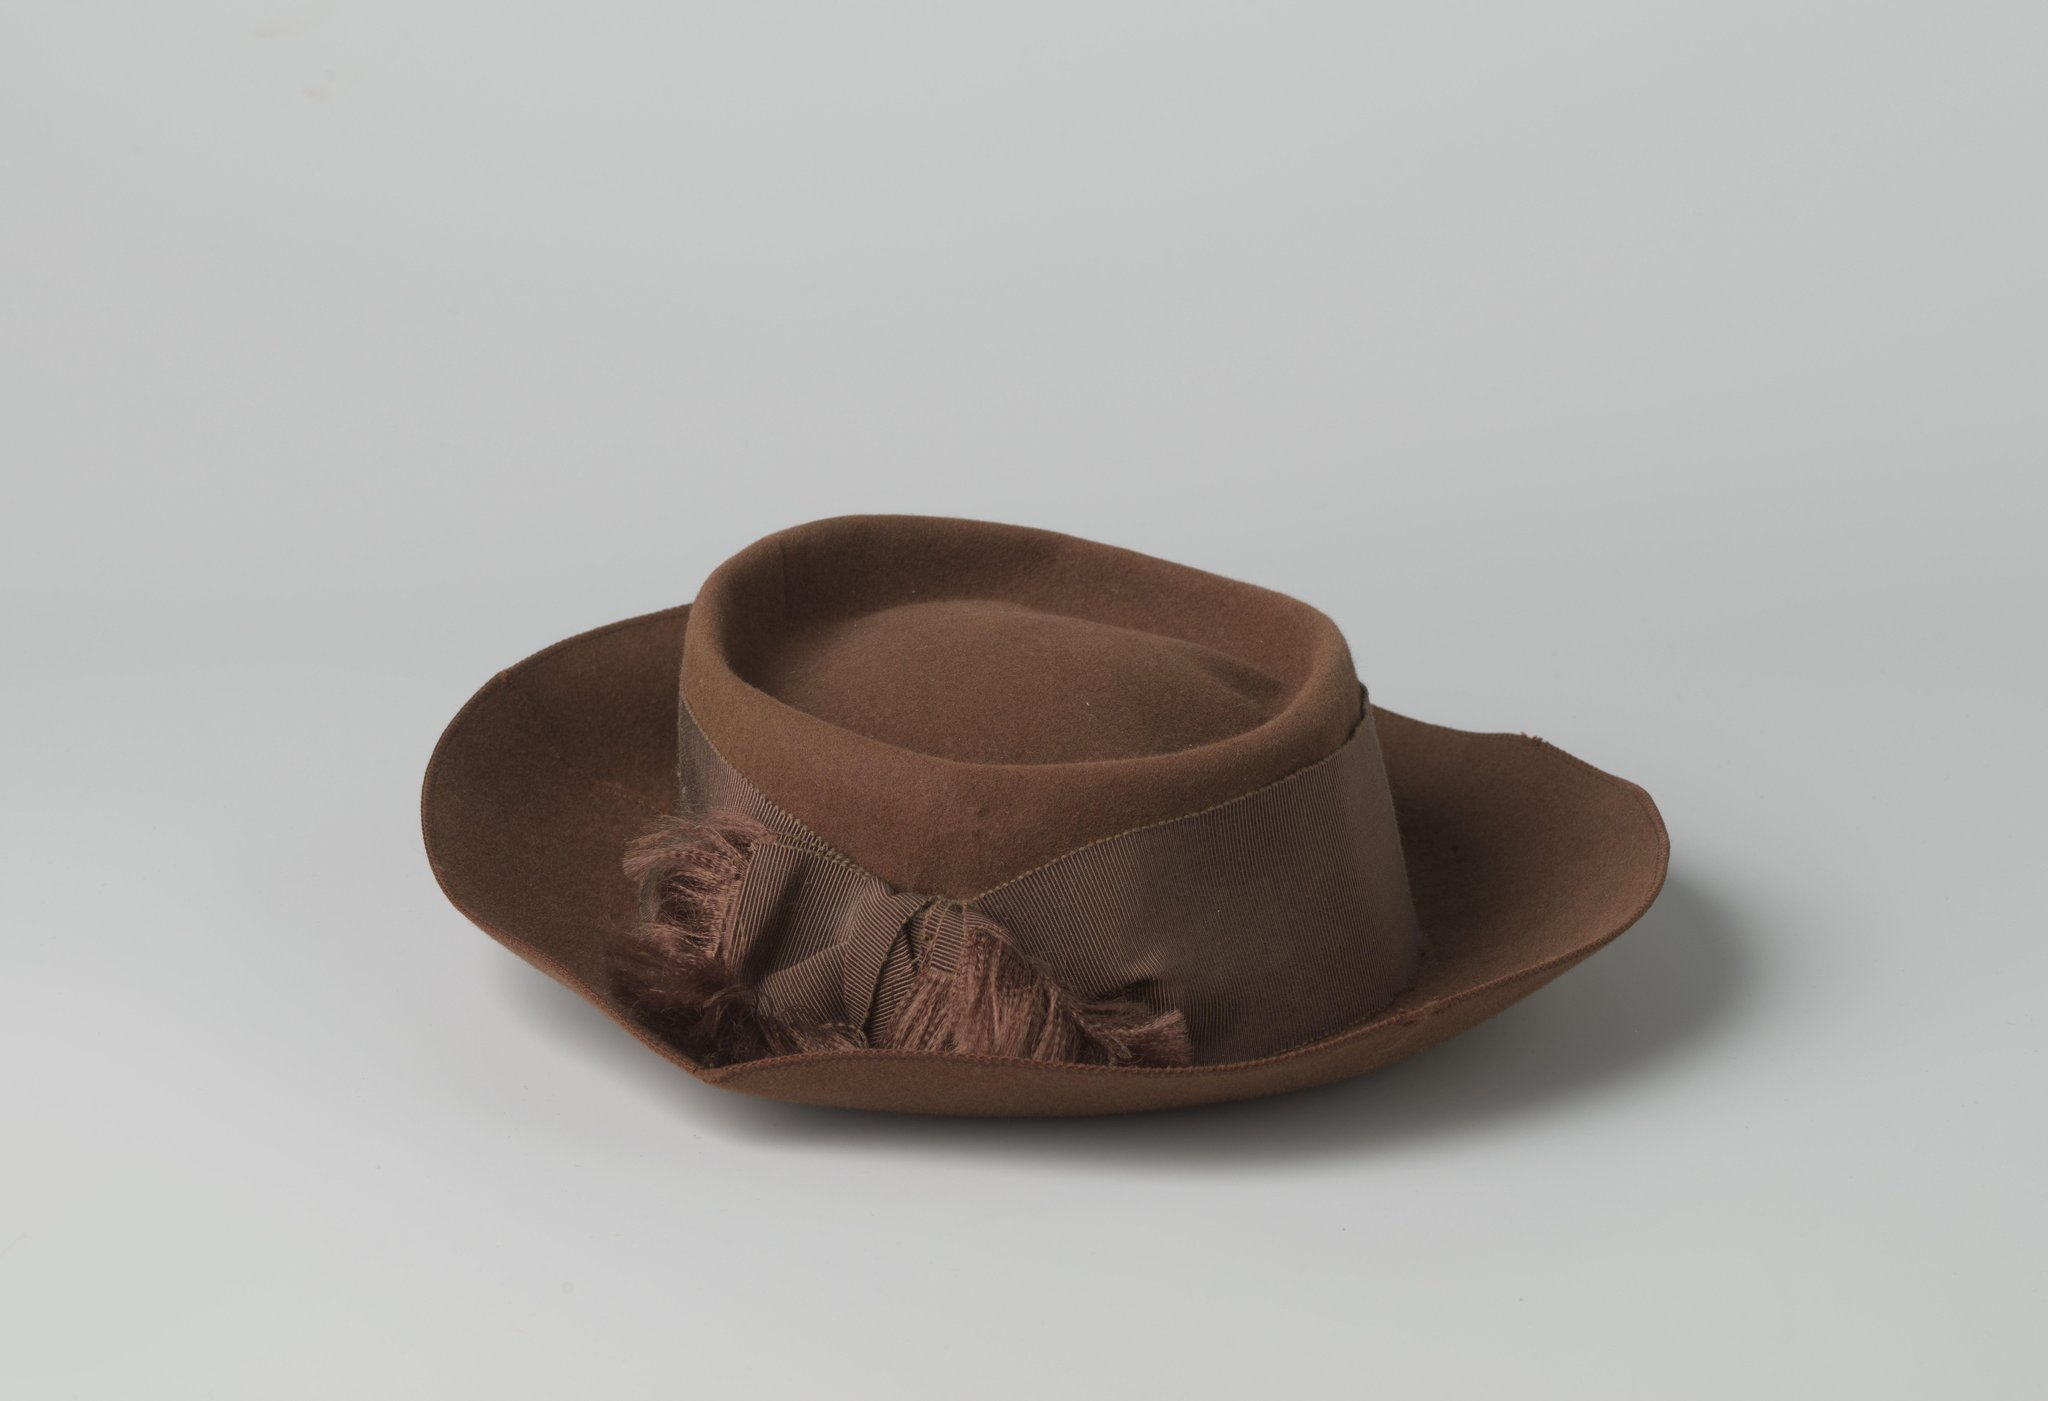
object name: womenswear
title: Hoed van bruin vilt met opstaande rand en licht verzonken bol voorzien van bruin grosgrain met strik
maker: rose descat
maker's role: modiste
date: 1938-1940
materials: felt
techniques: weave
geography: paris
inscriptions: name: ‘Rose Descat/ 22, Rue Royale/ Paris’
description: Hoed van bruin vilt met opstaande rand en licht verzonken bol voorzien van bruin grosgrain met strik. Model: losse bol en rand. De bol bestaat uit één stuk vilt met een naad middenachter. De bol is verzonken. De rand staat licht op en is geheel gefestonneerd. Ongevoerd. Bruin ripslint en bruin hoedenelastiek. Versiering: om de bol een 5 cm breed lint van bruin grosgrain dat aan de rechterkant gestrikt is en aan de uiteinden gerafeld.